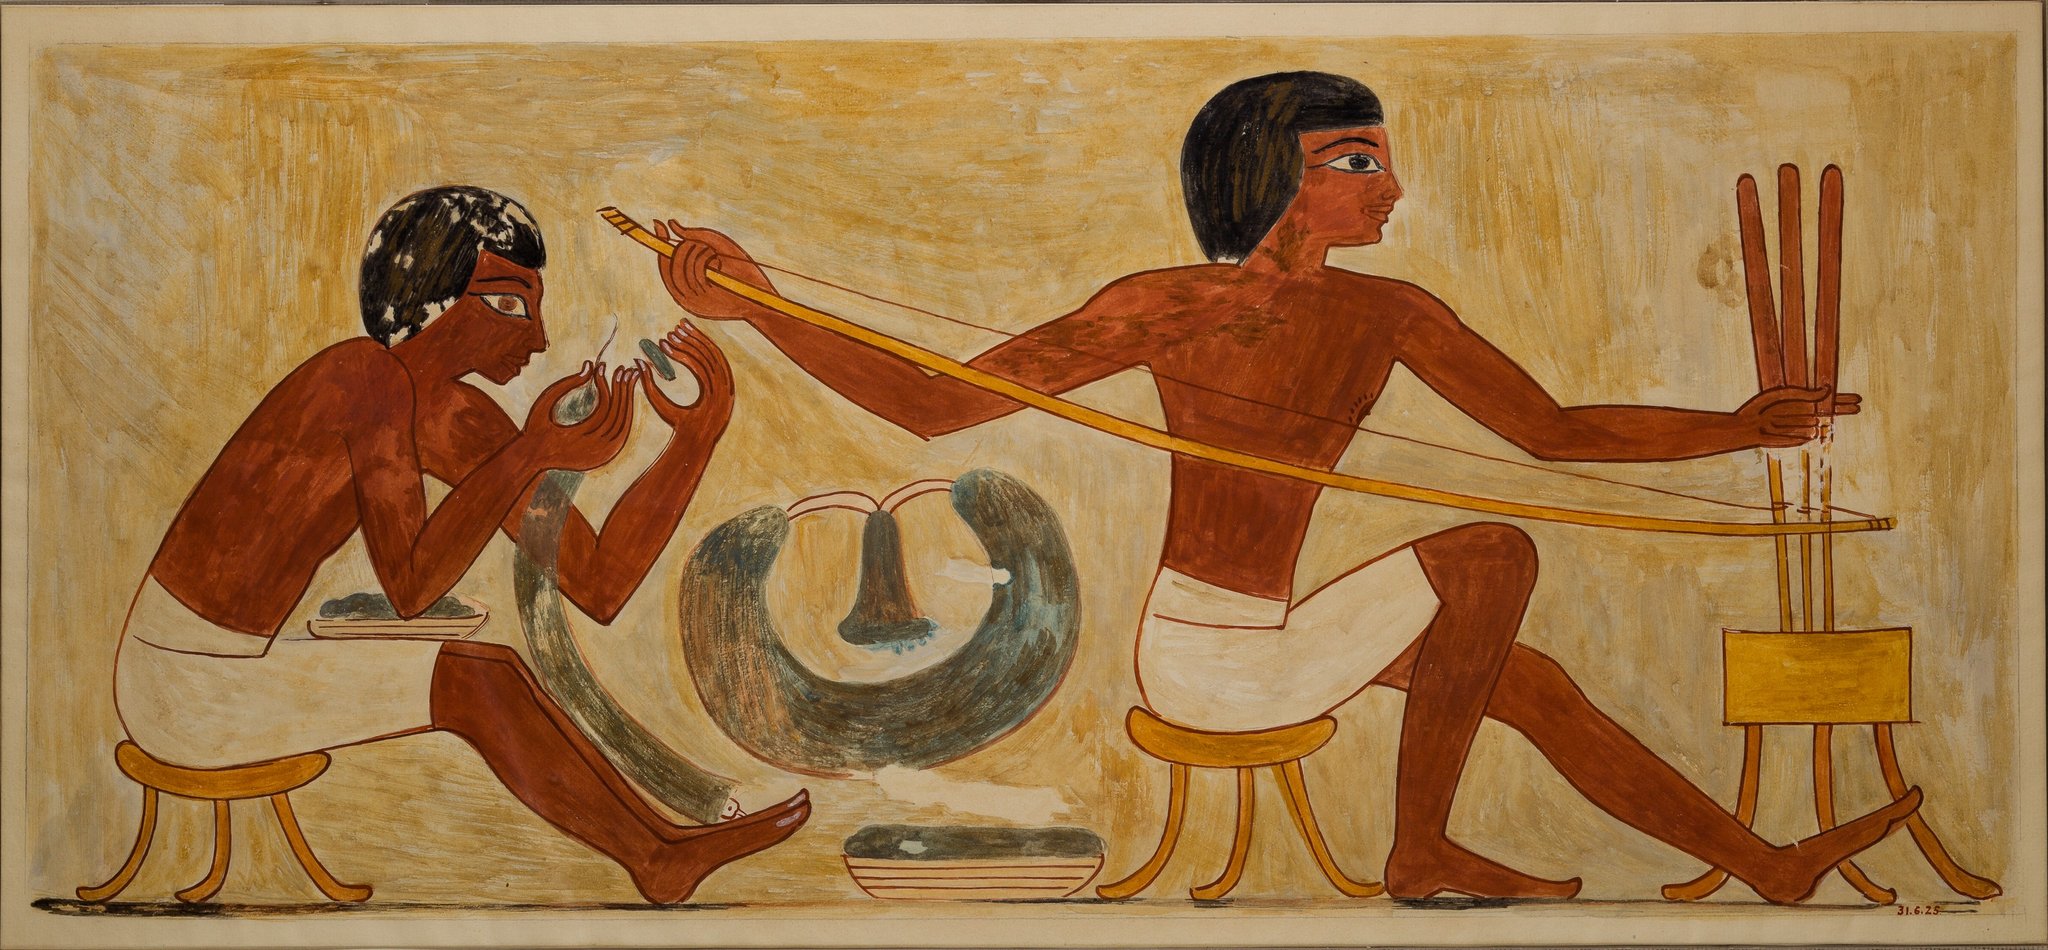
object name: facsimile, rekhmire tt 100, jewelry making, bow drill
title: Stringing and Drilling Beads, Tomb of Rekhmire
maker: nina de garis davies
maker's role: artist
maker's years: 1881-1965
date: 1504-1425 BCE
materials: ink, paint, paper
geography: egypt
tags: men,working,rekhmire-exhibition